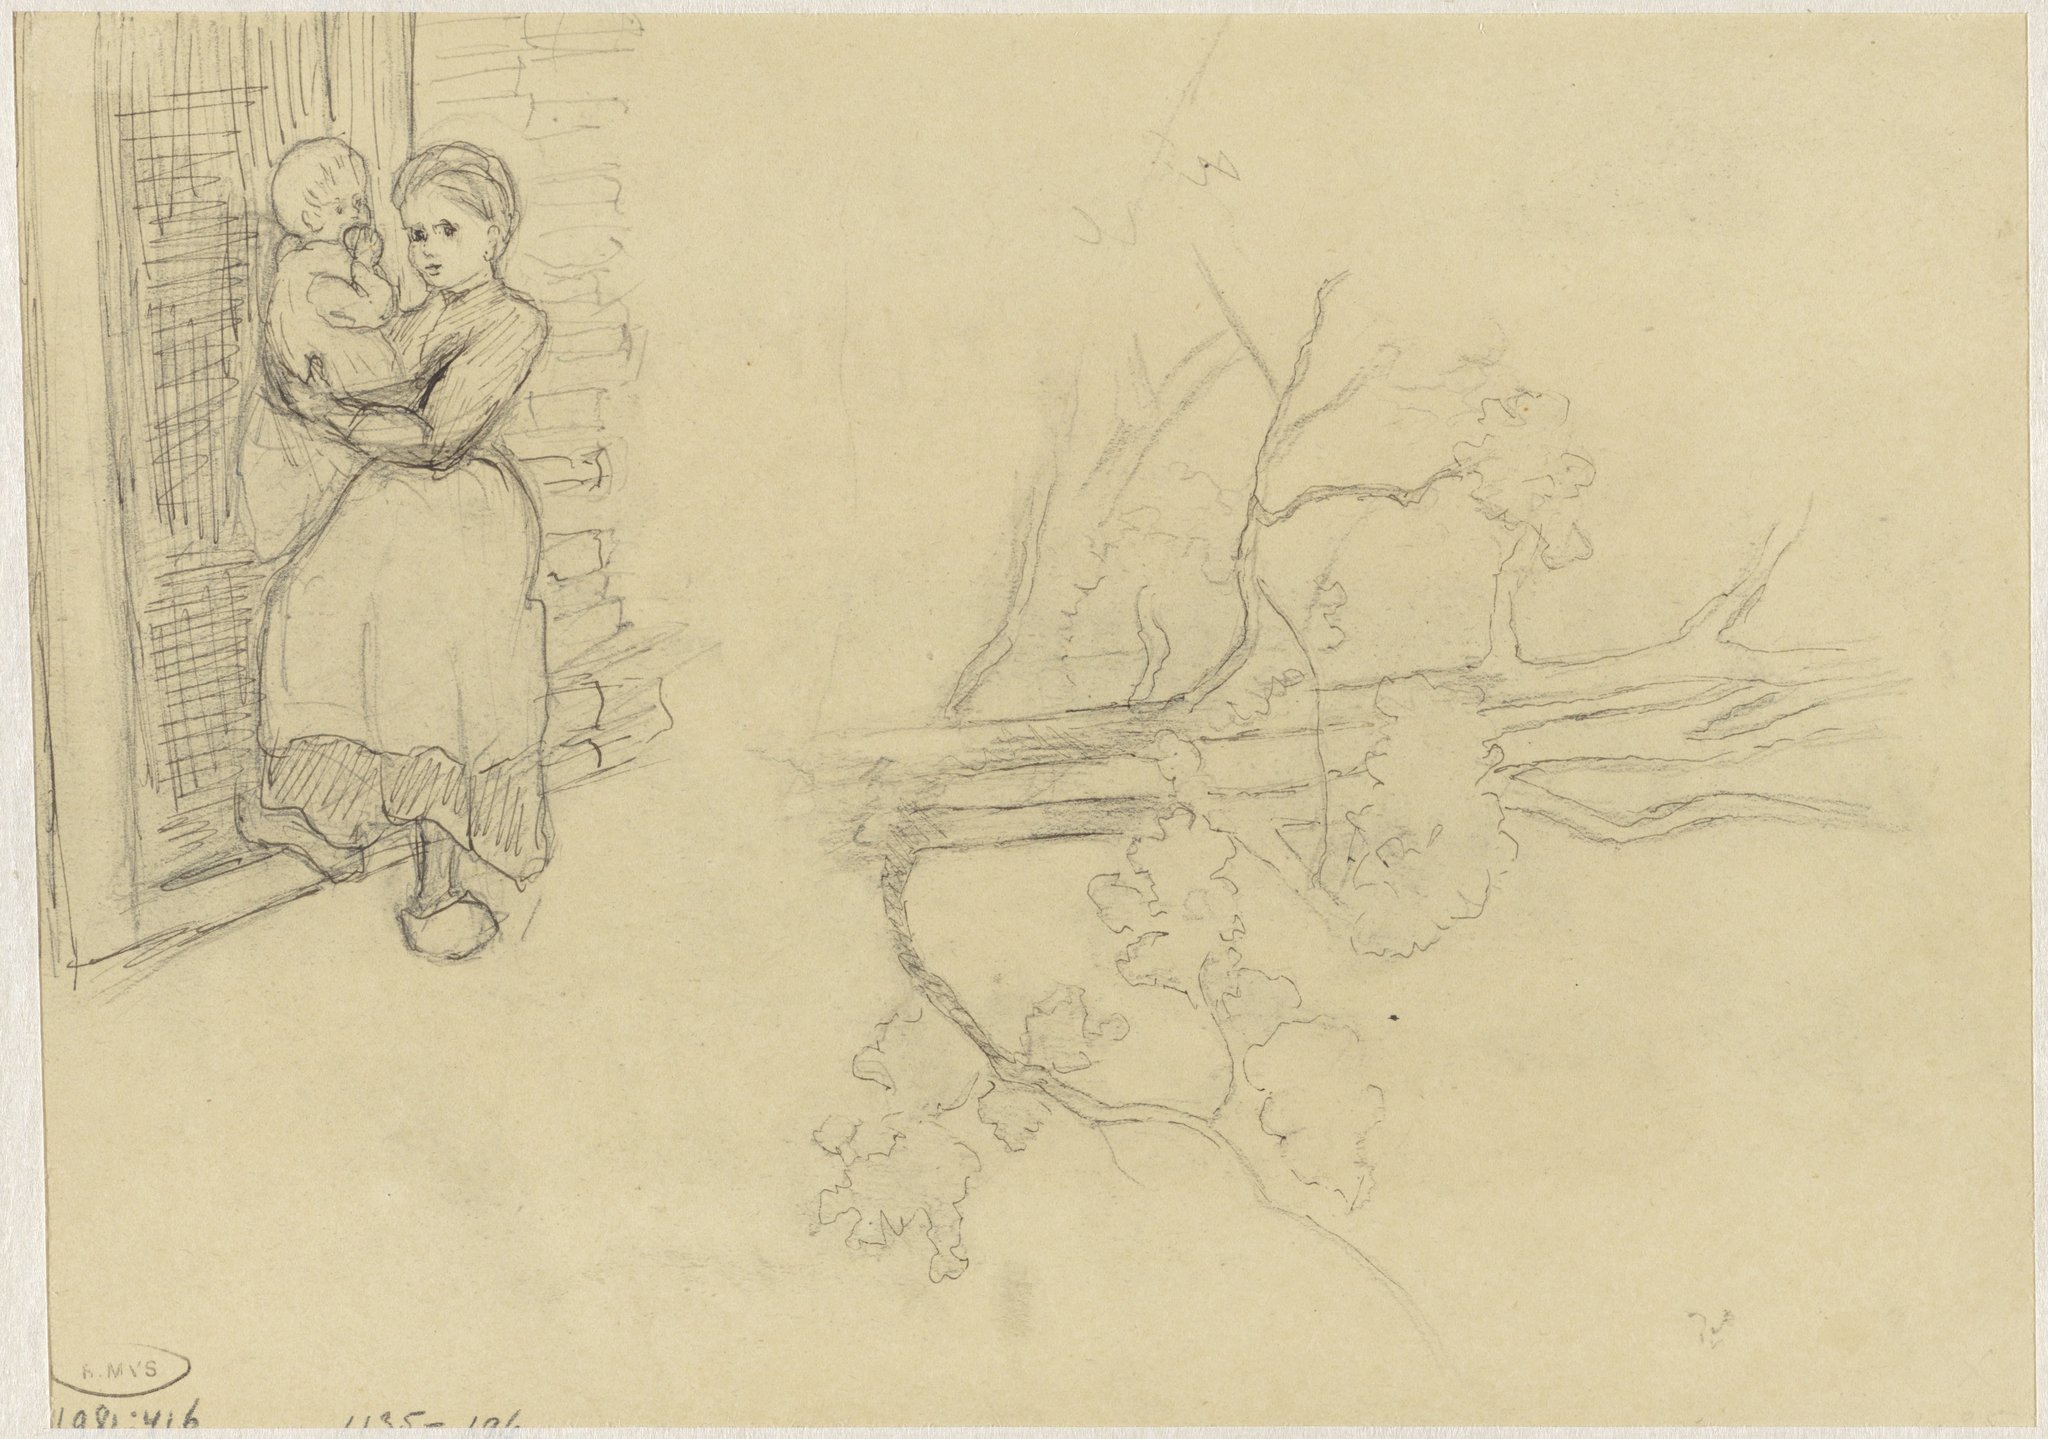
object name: drawing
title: Meisje met kind en studie van een boom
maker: jozef israëls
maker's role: draughtsman, painter, print maker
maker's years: 1824-1911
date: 1834-1911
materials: ink, paper, pencil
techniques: pen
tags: trees